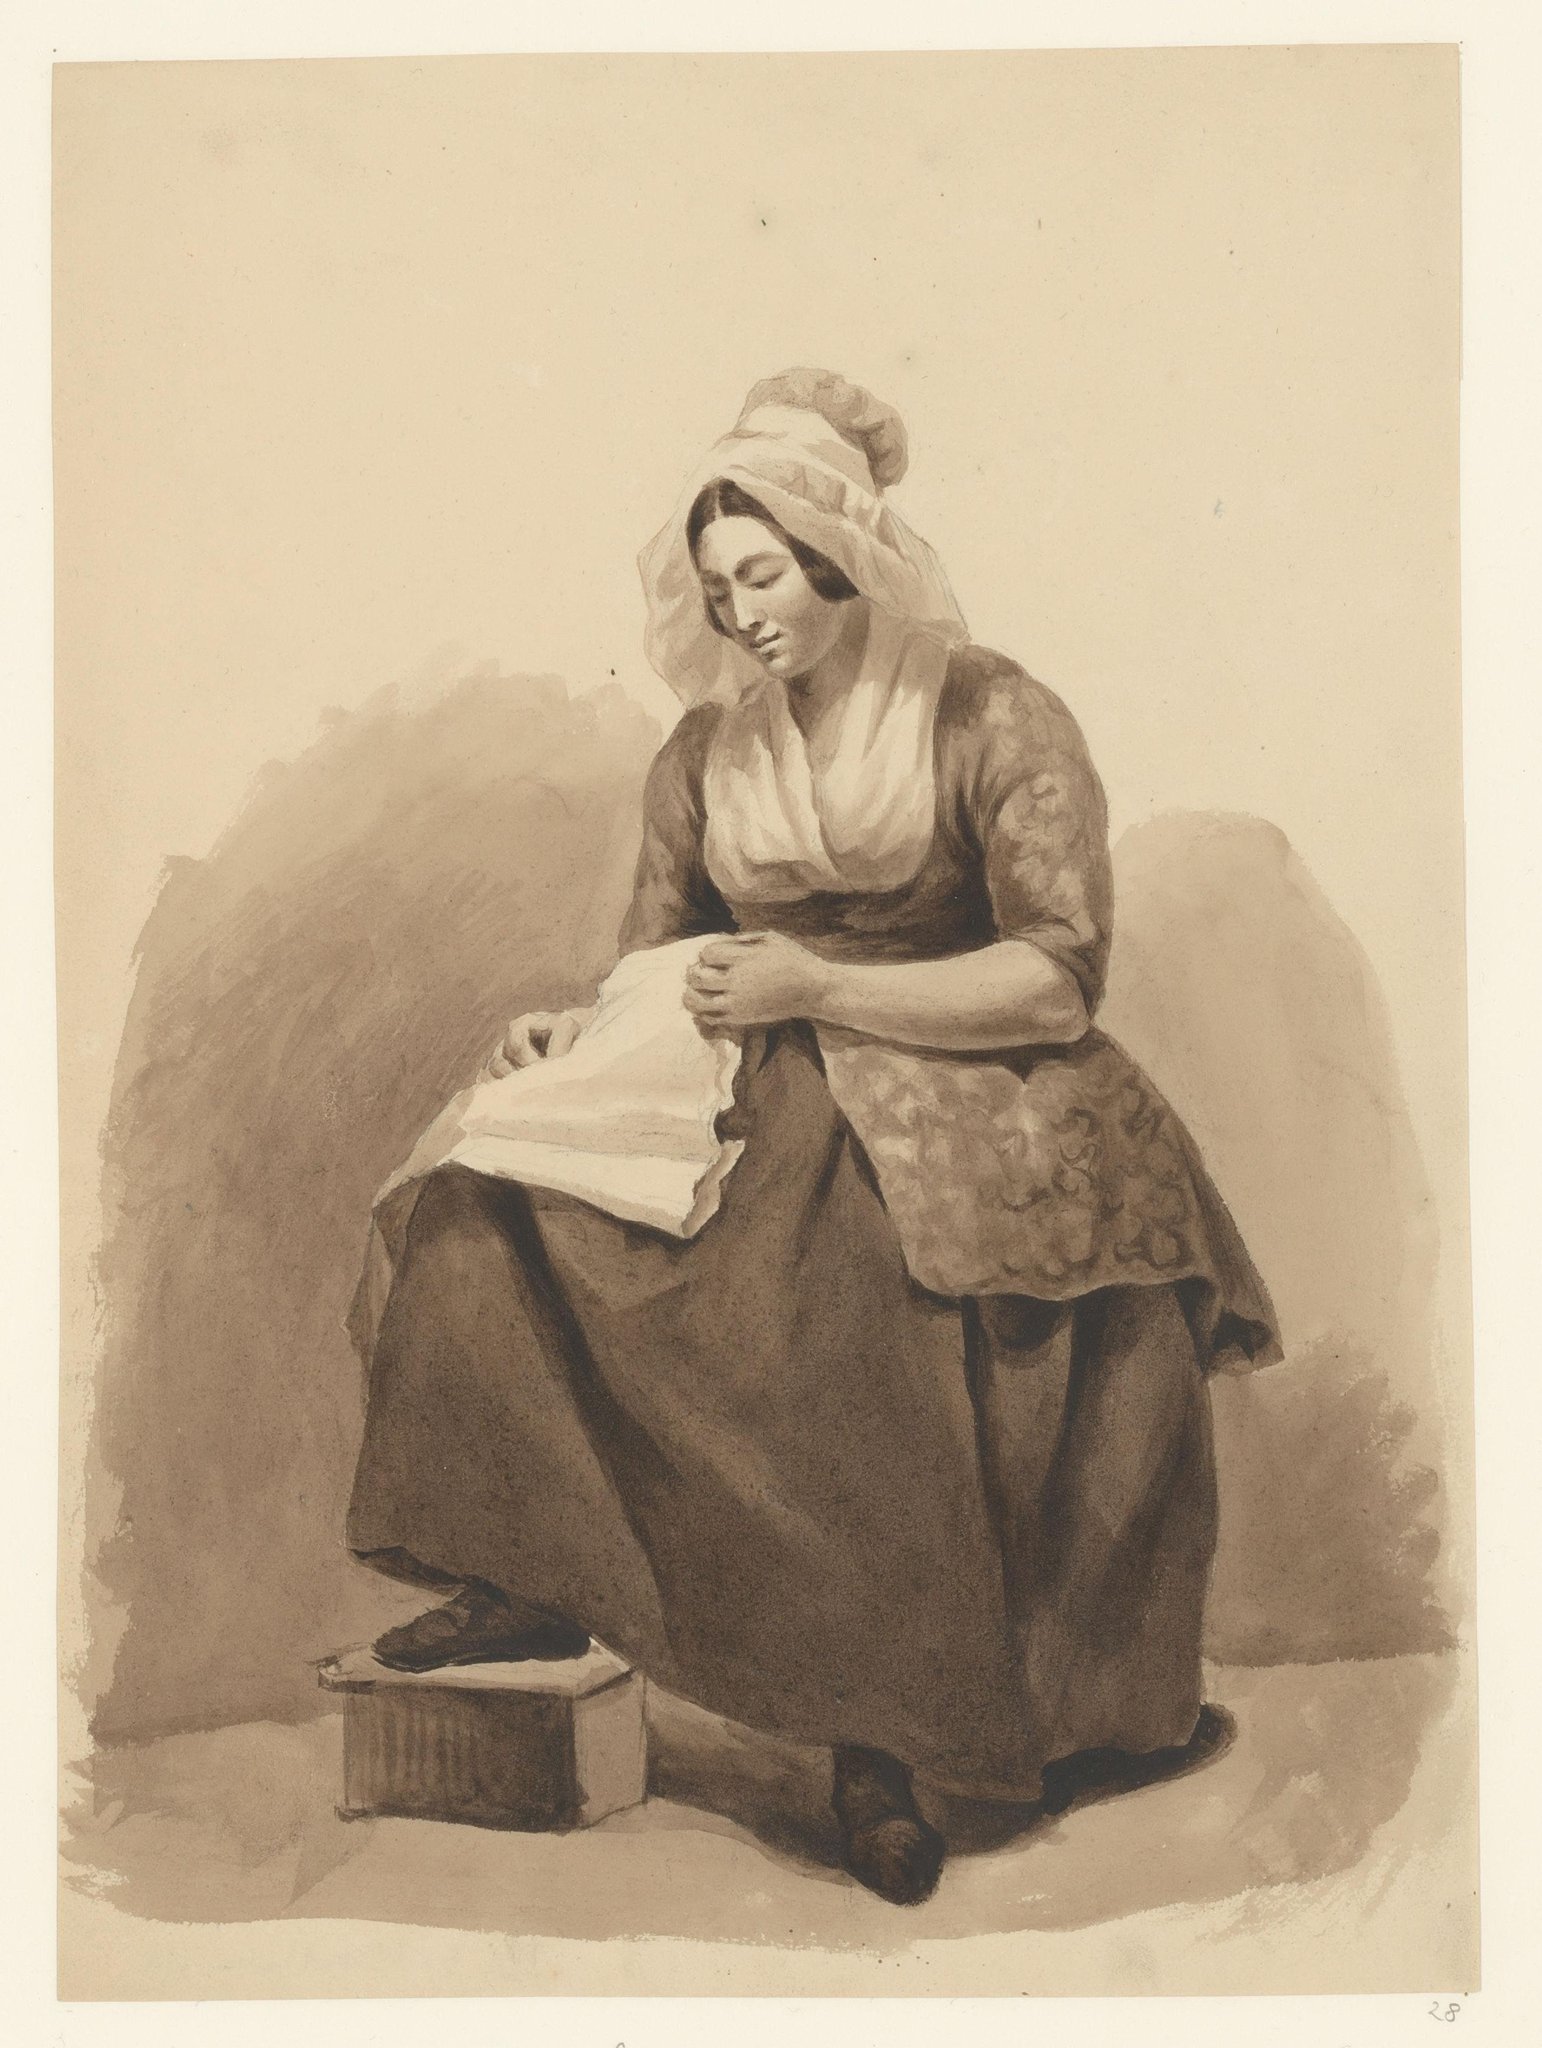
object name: drawing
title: Linnenmeid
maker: Anonymous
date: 1800-1850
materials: ink, paper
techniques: brush, pen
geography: netherlands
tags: care and laundering of clothes; home sewing, maid ~ house personnel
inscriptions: collector's mark: Lugt 1641, collector's mark: Lugt 1641a, collector's mark:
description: Een dienstmeid, zittend een doek op haar schoot vouwend. Onderwerpsrubrieken binnen de Atlas Zeden en Gewoonten: Beroep en bedrijf. Vrouwelijk beroep en bedrijf. Dienstboden.